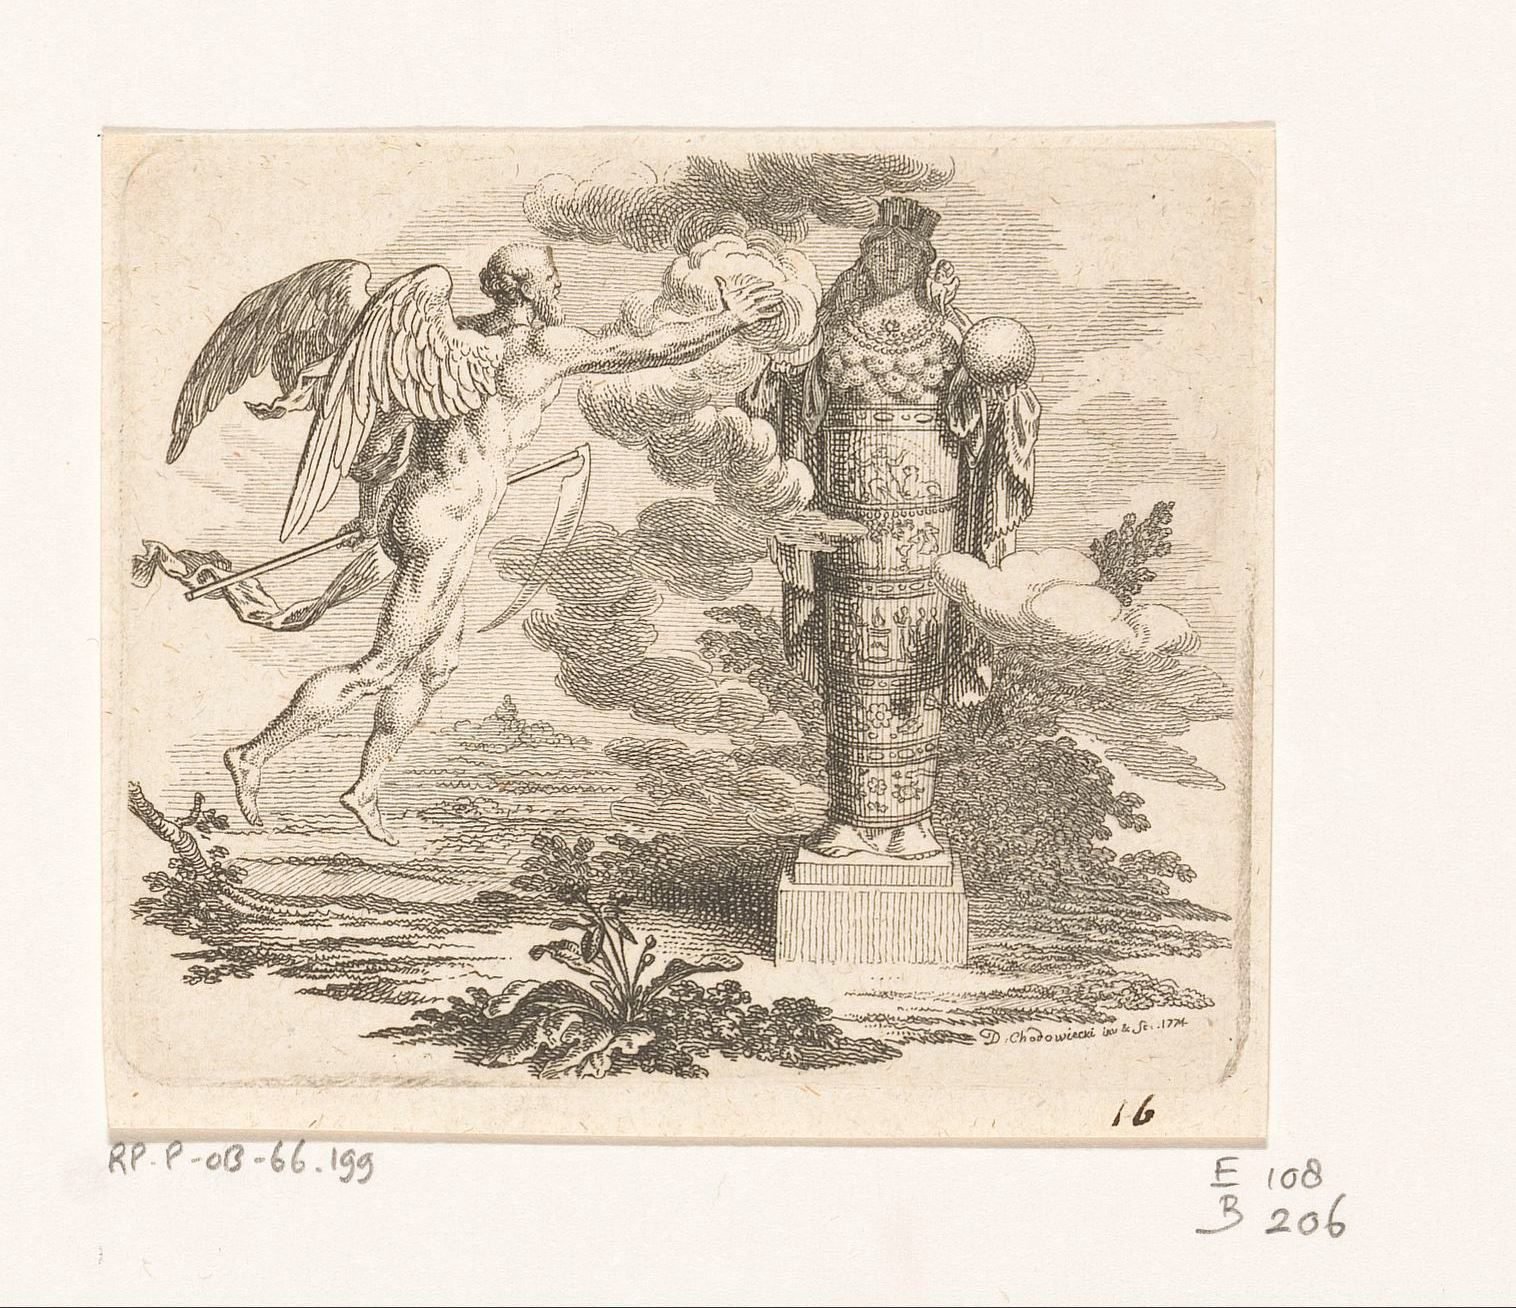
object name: print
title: Tijd onthult de Waarheid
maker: daniel nikolaus chodowiecki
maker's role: draughtsman, print maker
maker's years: 1726-1801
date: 1774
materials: paper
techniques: etching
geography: berlin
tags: 'natura' (allegorical figure or scene; or as diana of ephesus, with many breasts); 'natura' (ripa), time revealing truth; time carrying truth aloft, father time, man with wings and scythe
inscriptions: inscription: ‘16’, collector's mark: Lugt 240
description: Tijd, een oude man met vleugels en een zeis, verjaagt de wolken voor een beeld van de natuur, voorgesteld als Diana van Efeze met in haar linkerhand een wereldbol.